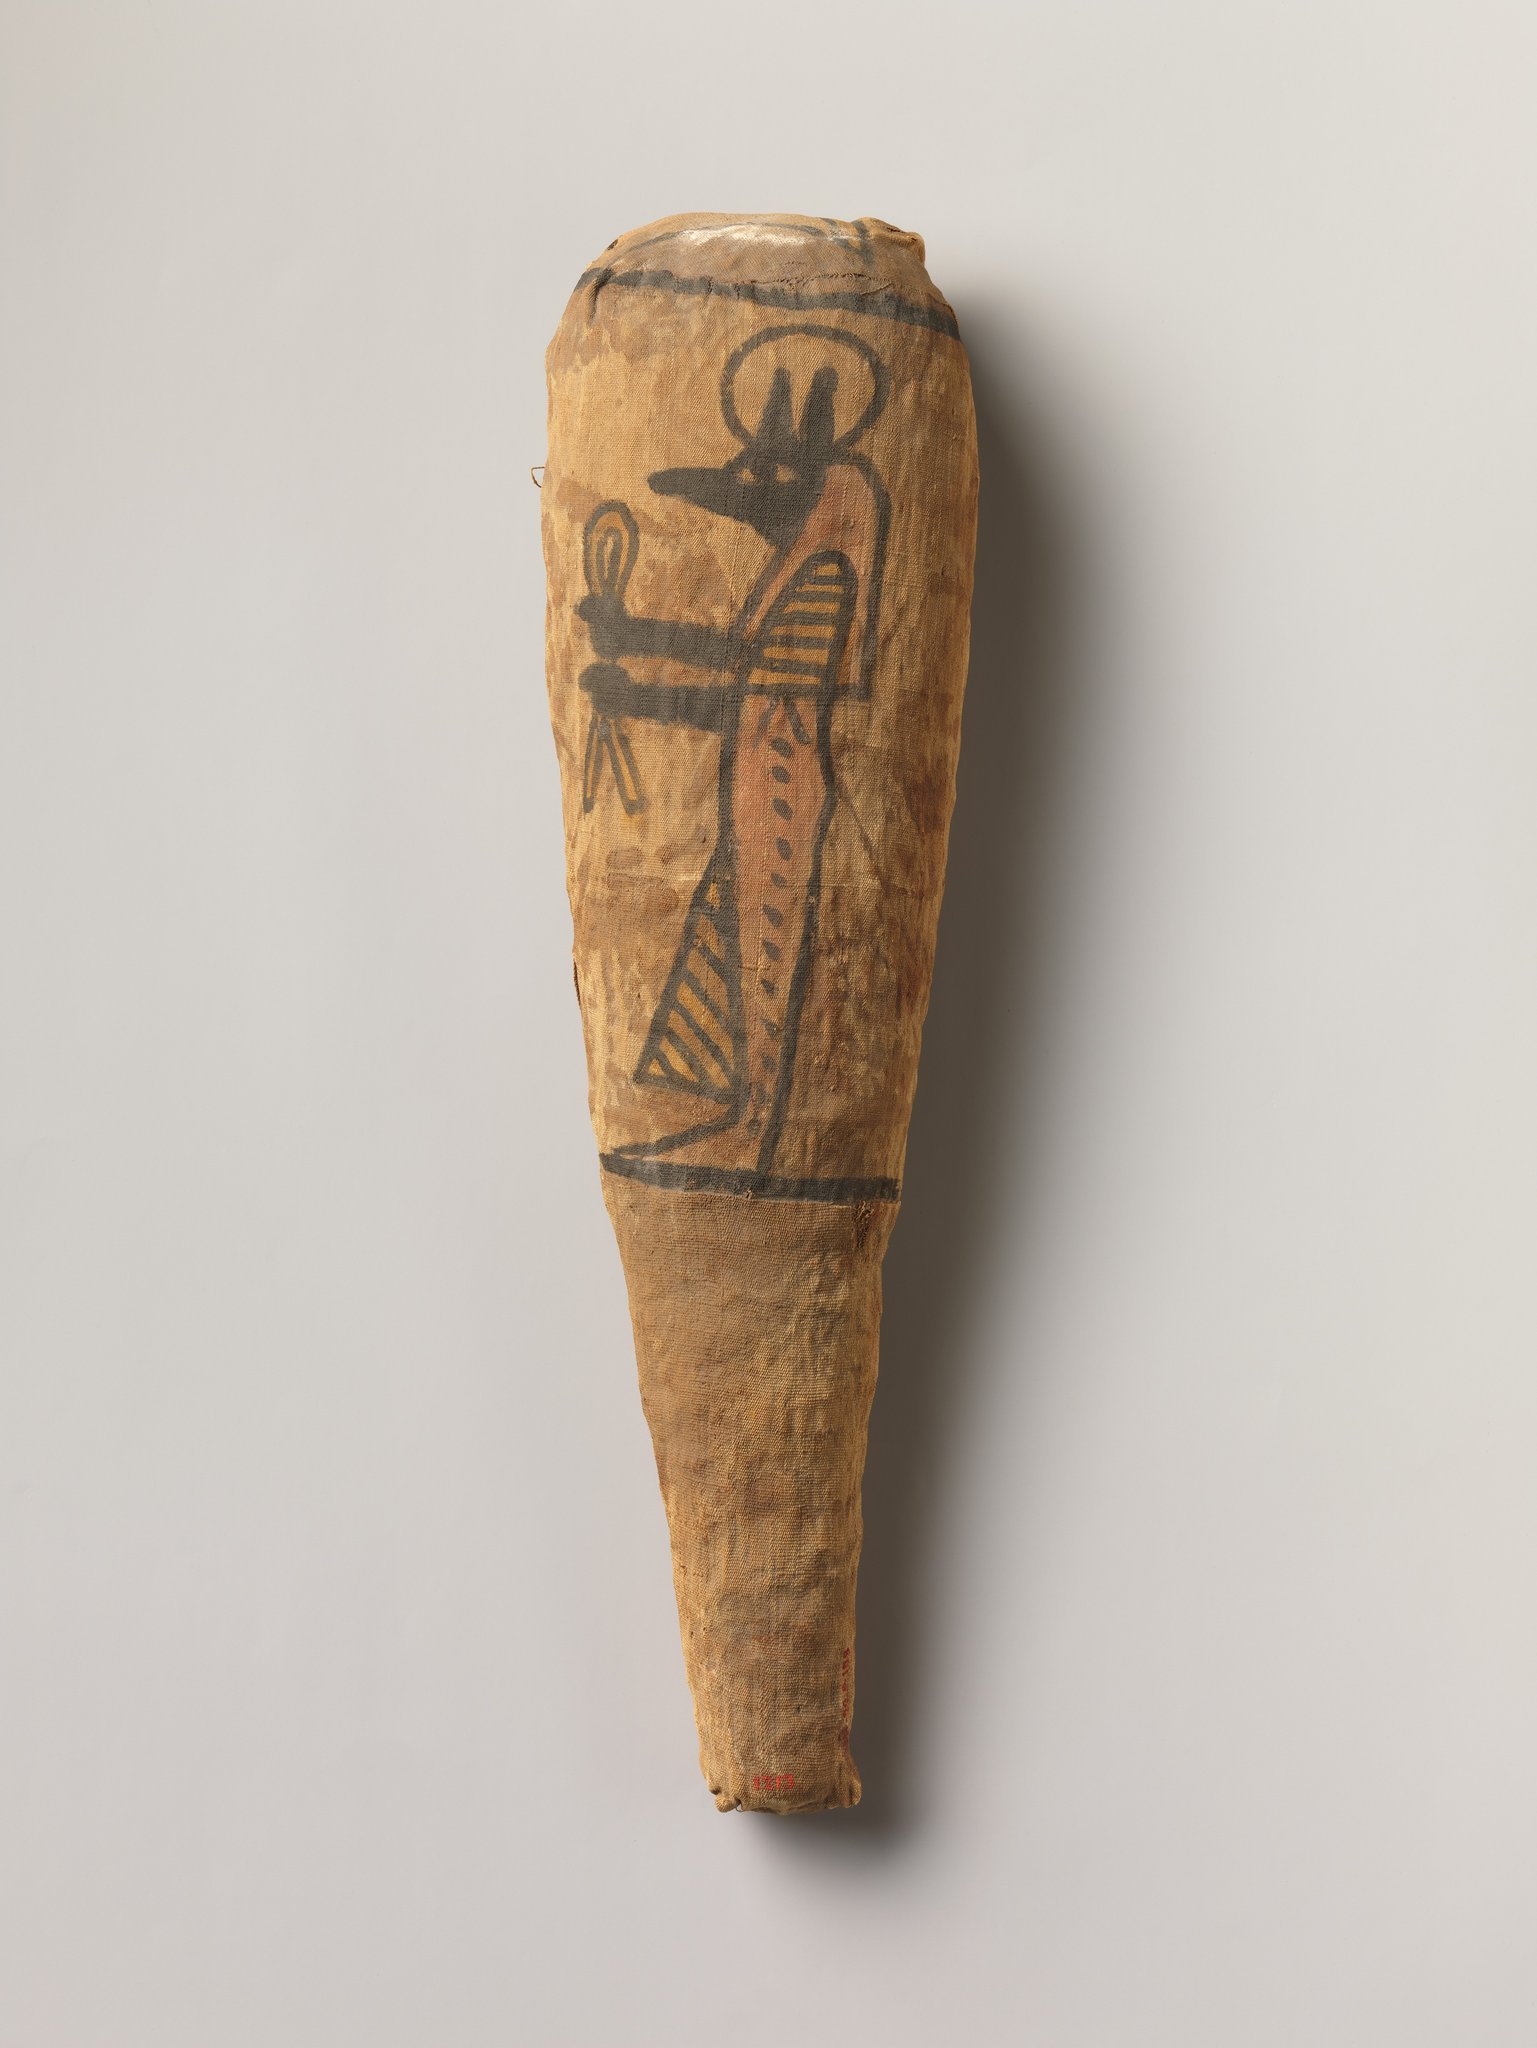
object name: mummy, ibis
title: Sacred animal mummy in the form typical of a wrapped ibis, decorated with a figure of Duamutef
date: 400 BCE-100 CE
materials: linen, paint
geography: egypt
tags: mummies